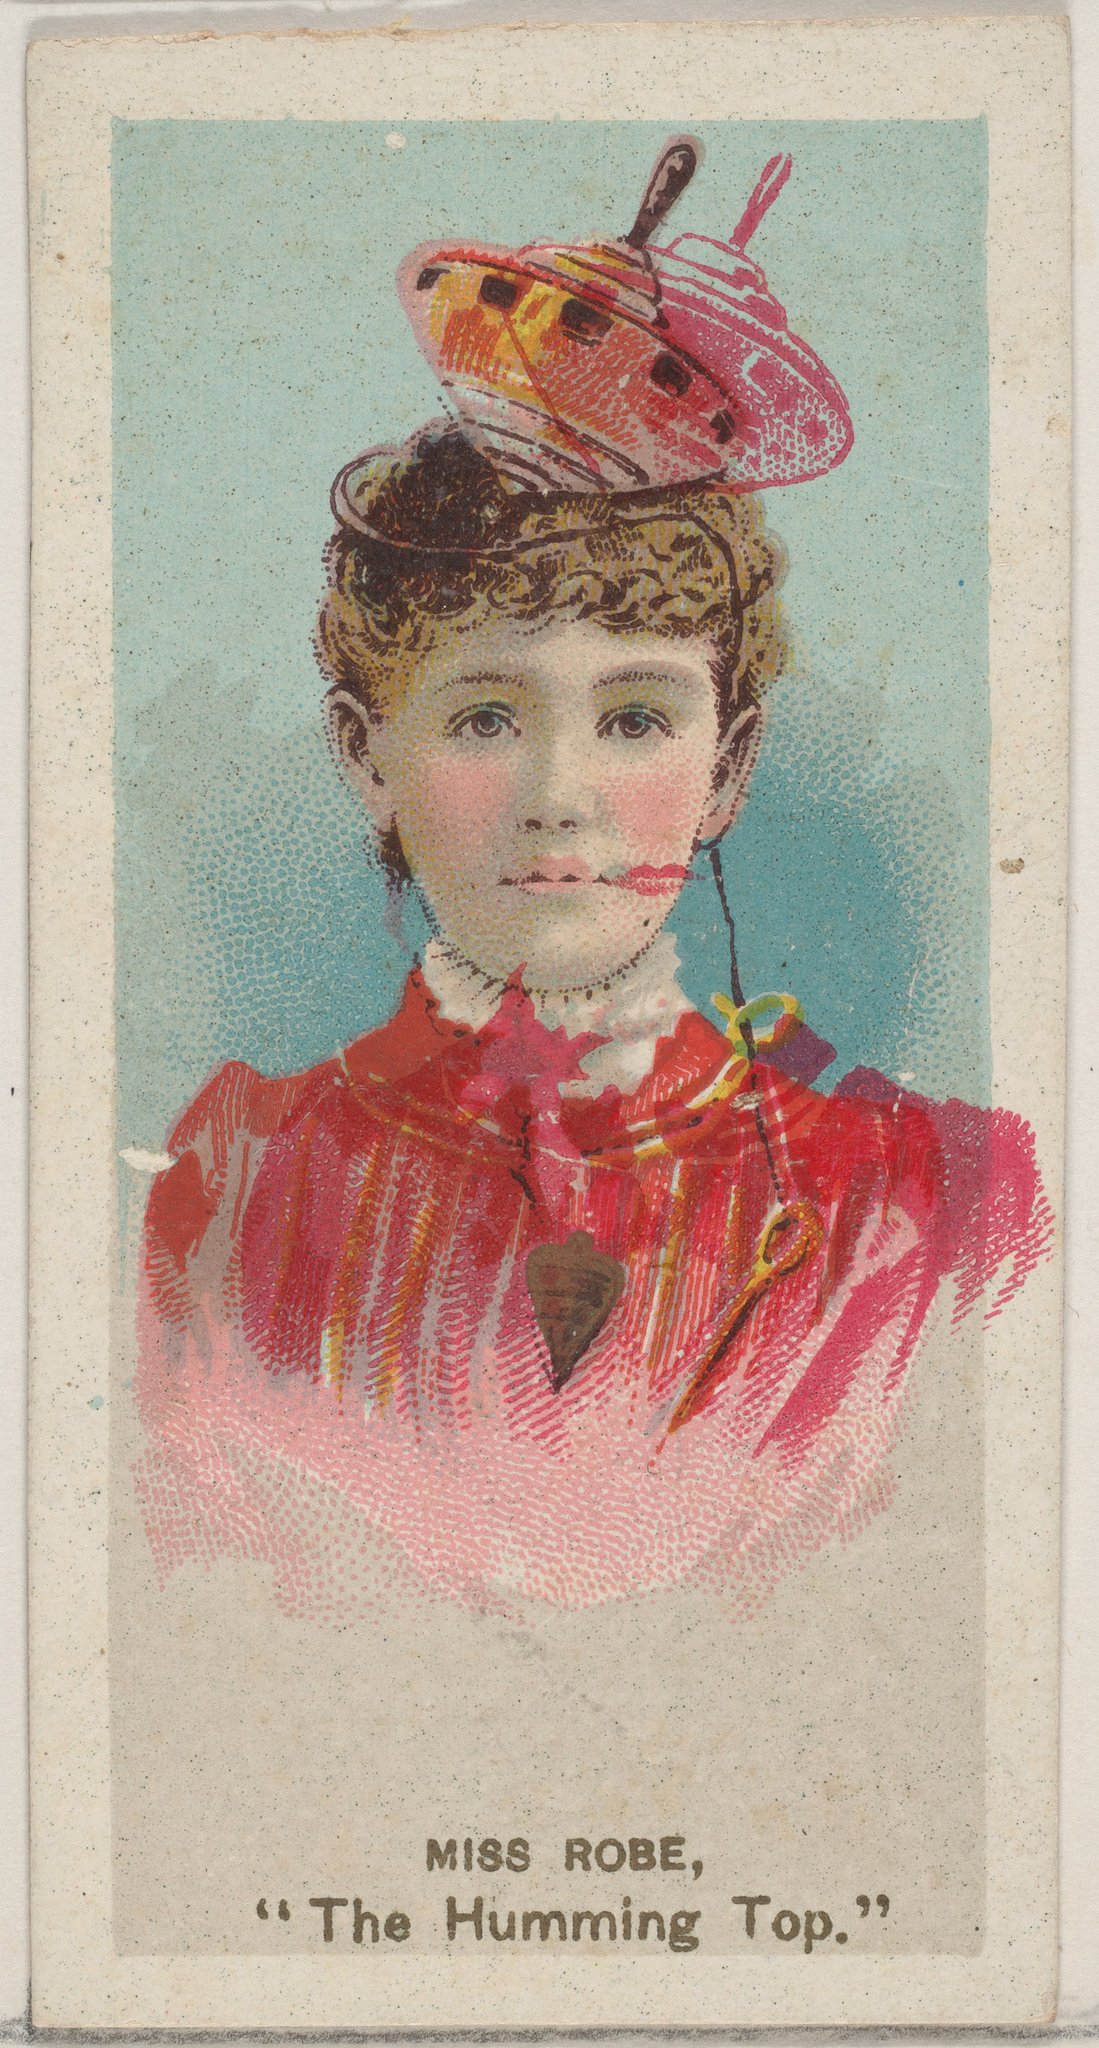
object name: print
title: Miss Robe as "The Humming Top," from the series Fancy Dress Ball Costumes (N73) for Duke brand cigarettes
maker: w. duke, sons & co.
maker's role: publisher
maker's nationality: american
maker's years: 1870-1920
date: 1889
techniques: color lithograph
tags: women,actresses